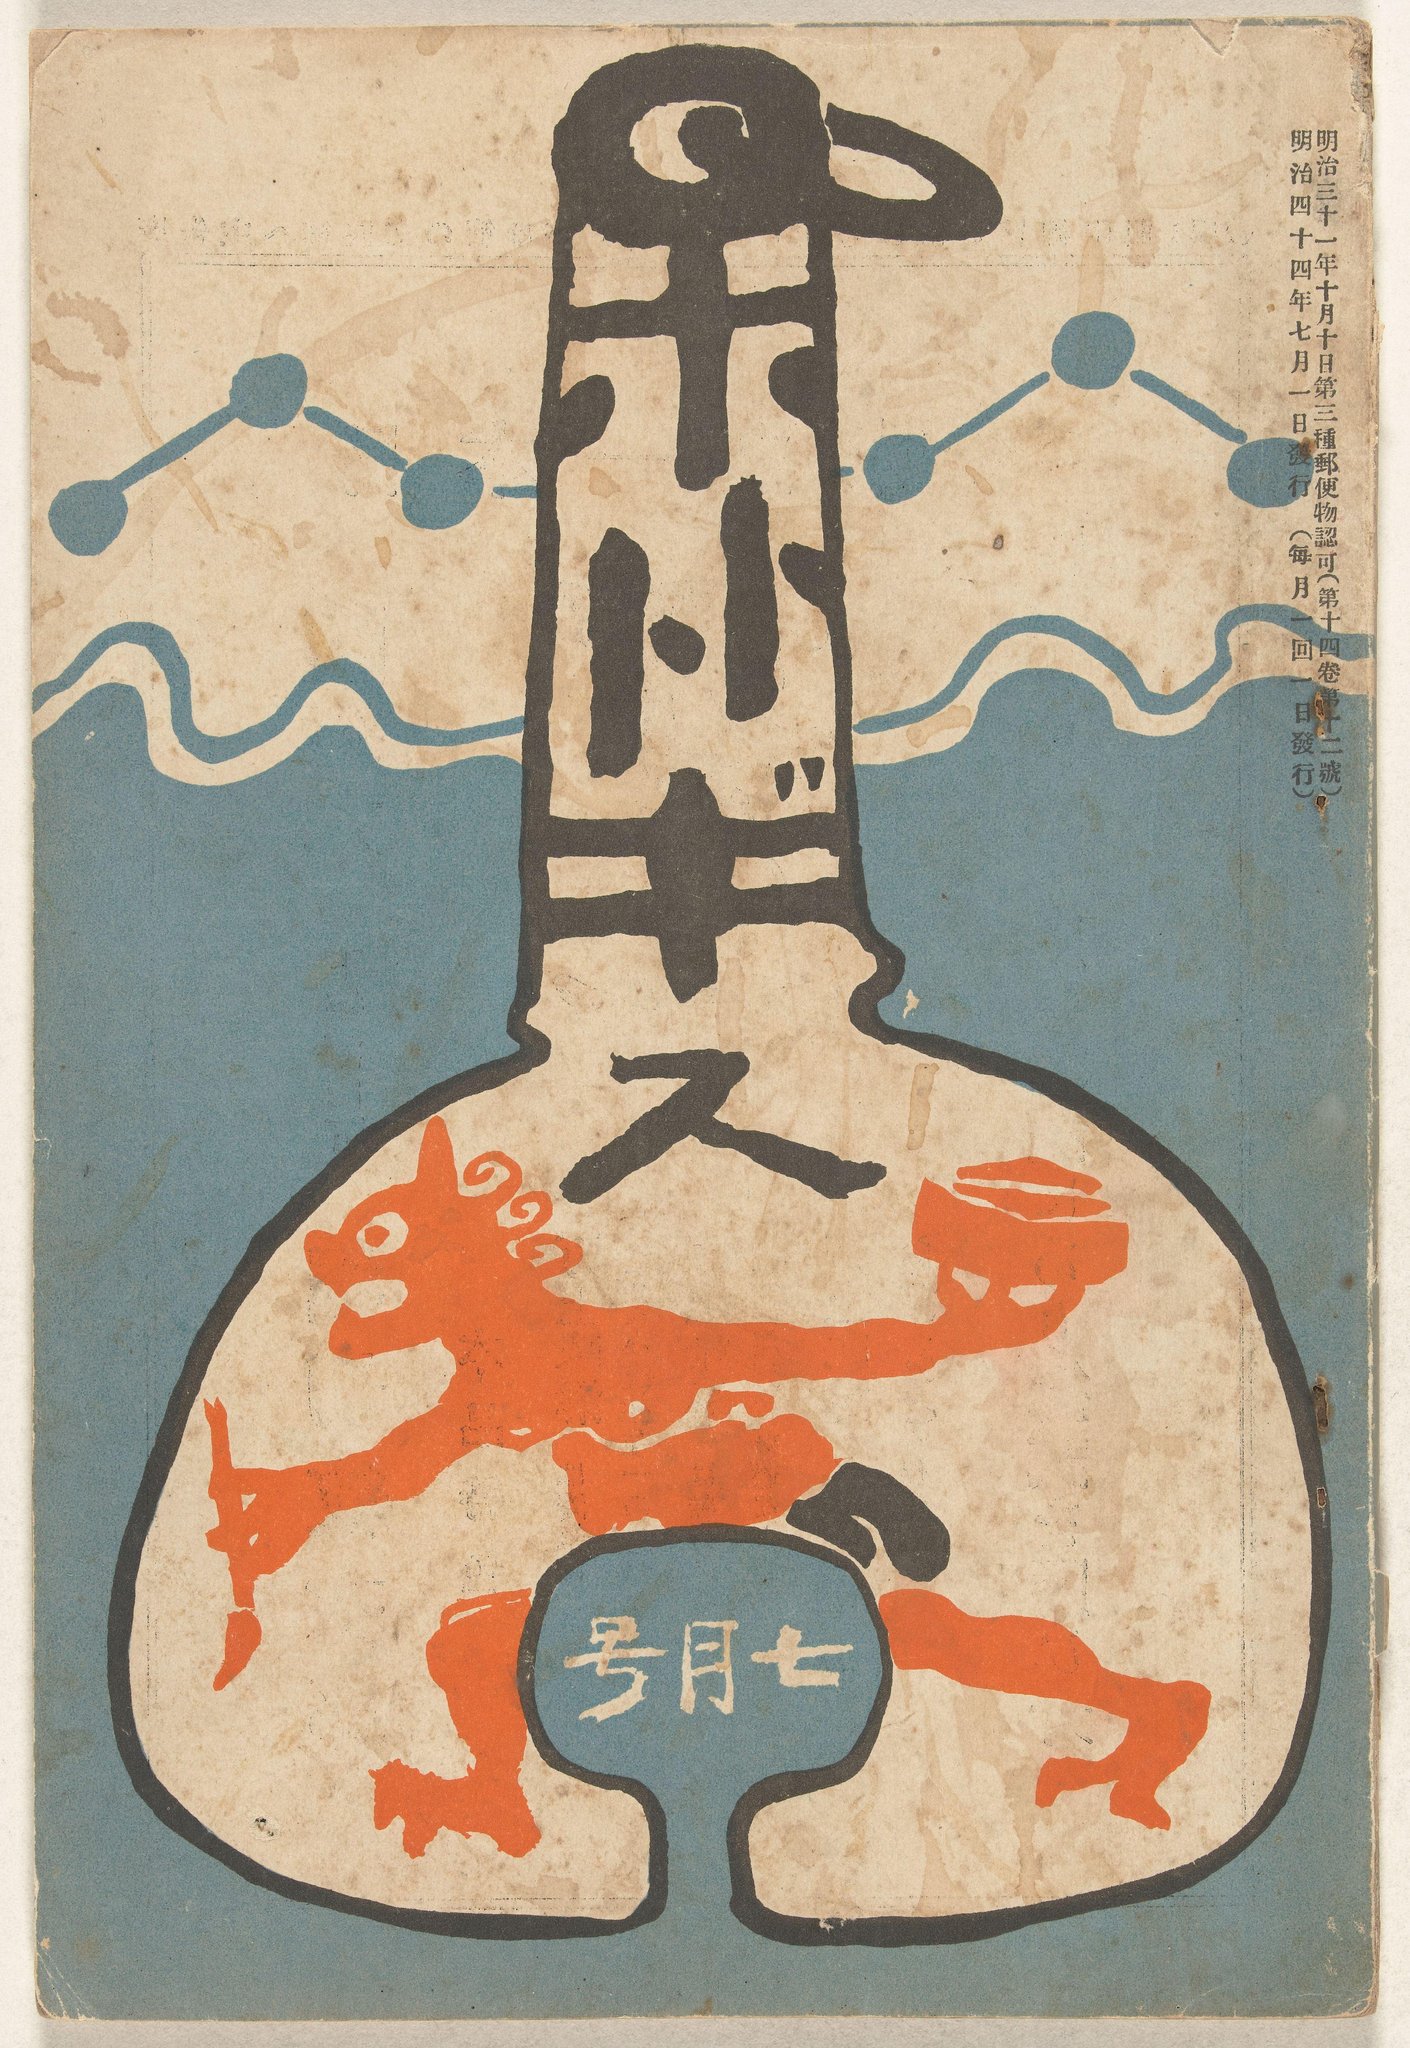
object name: magazine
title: Juli 1911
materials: paper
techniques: woodcut, letterpress printing, lithograph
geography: japan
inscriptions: date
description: Nummer 12 van jaargang 14 (juli 1911) van het literaire maandblad Hototogisu: blauwe kaft met sakefles waarop afbeelding van oranje duivel met penseel; achterkant, afbeelding van vrouw.